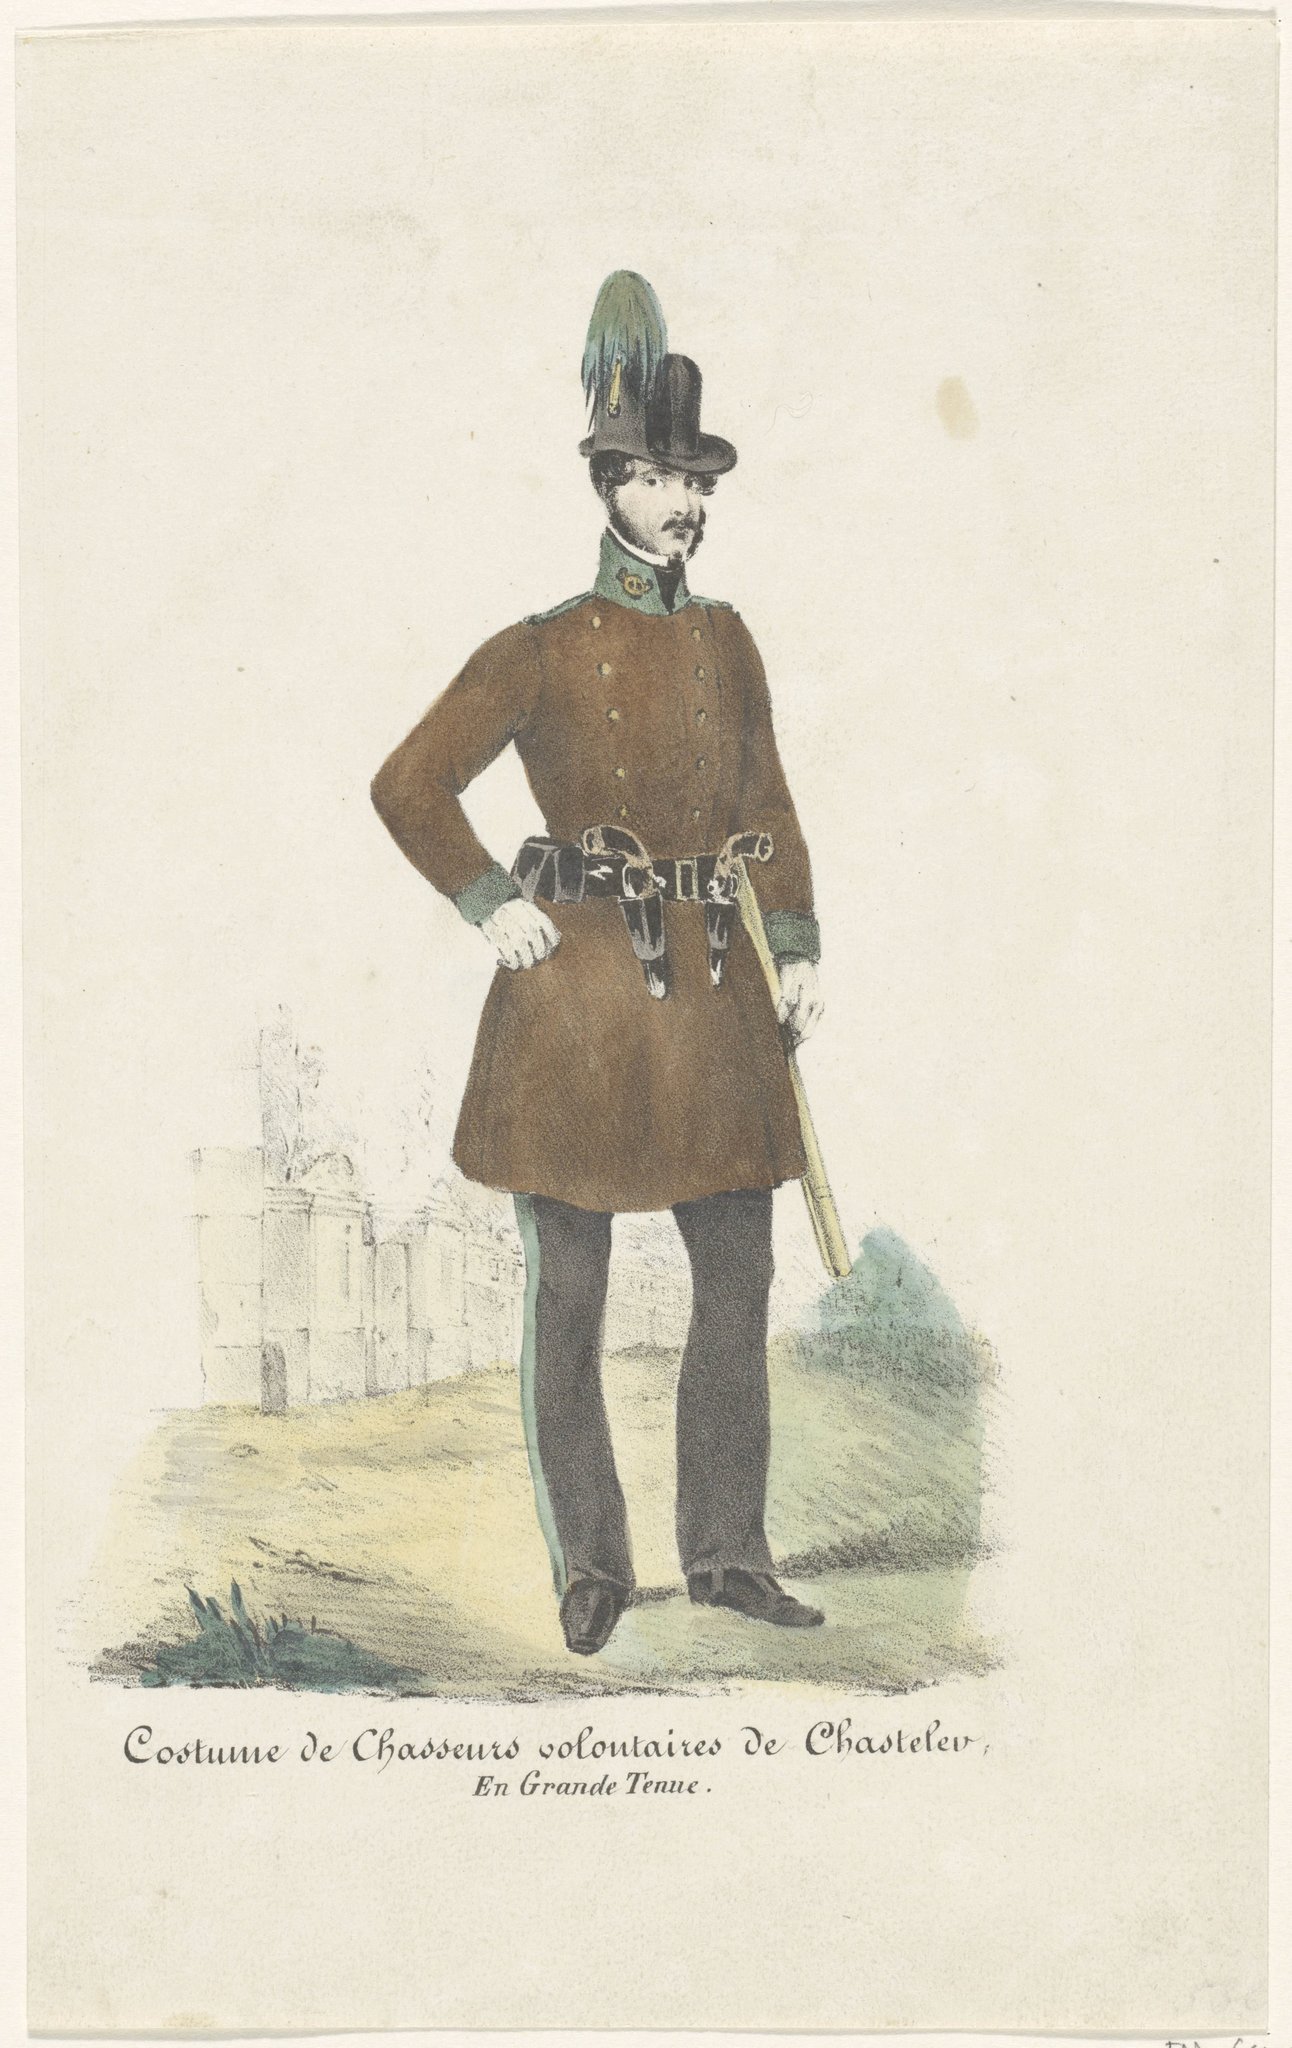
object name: print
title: Chasseur du Marquis de Chasteler, 1830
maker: Anonymous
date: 1830-1831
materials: paper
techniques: hand coloring, lithograph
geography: belgium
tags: (military) uniforms, clothes, costume, belgium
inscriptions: collector's mark: Lugt 2228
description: Een Belgische jager, een Chasseur du Marquis de Chasteler, een bataljon vrijwilligers opgericht in 1830. Onderdeel van een groep voorstellingen van Belgische uniformen.